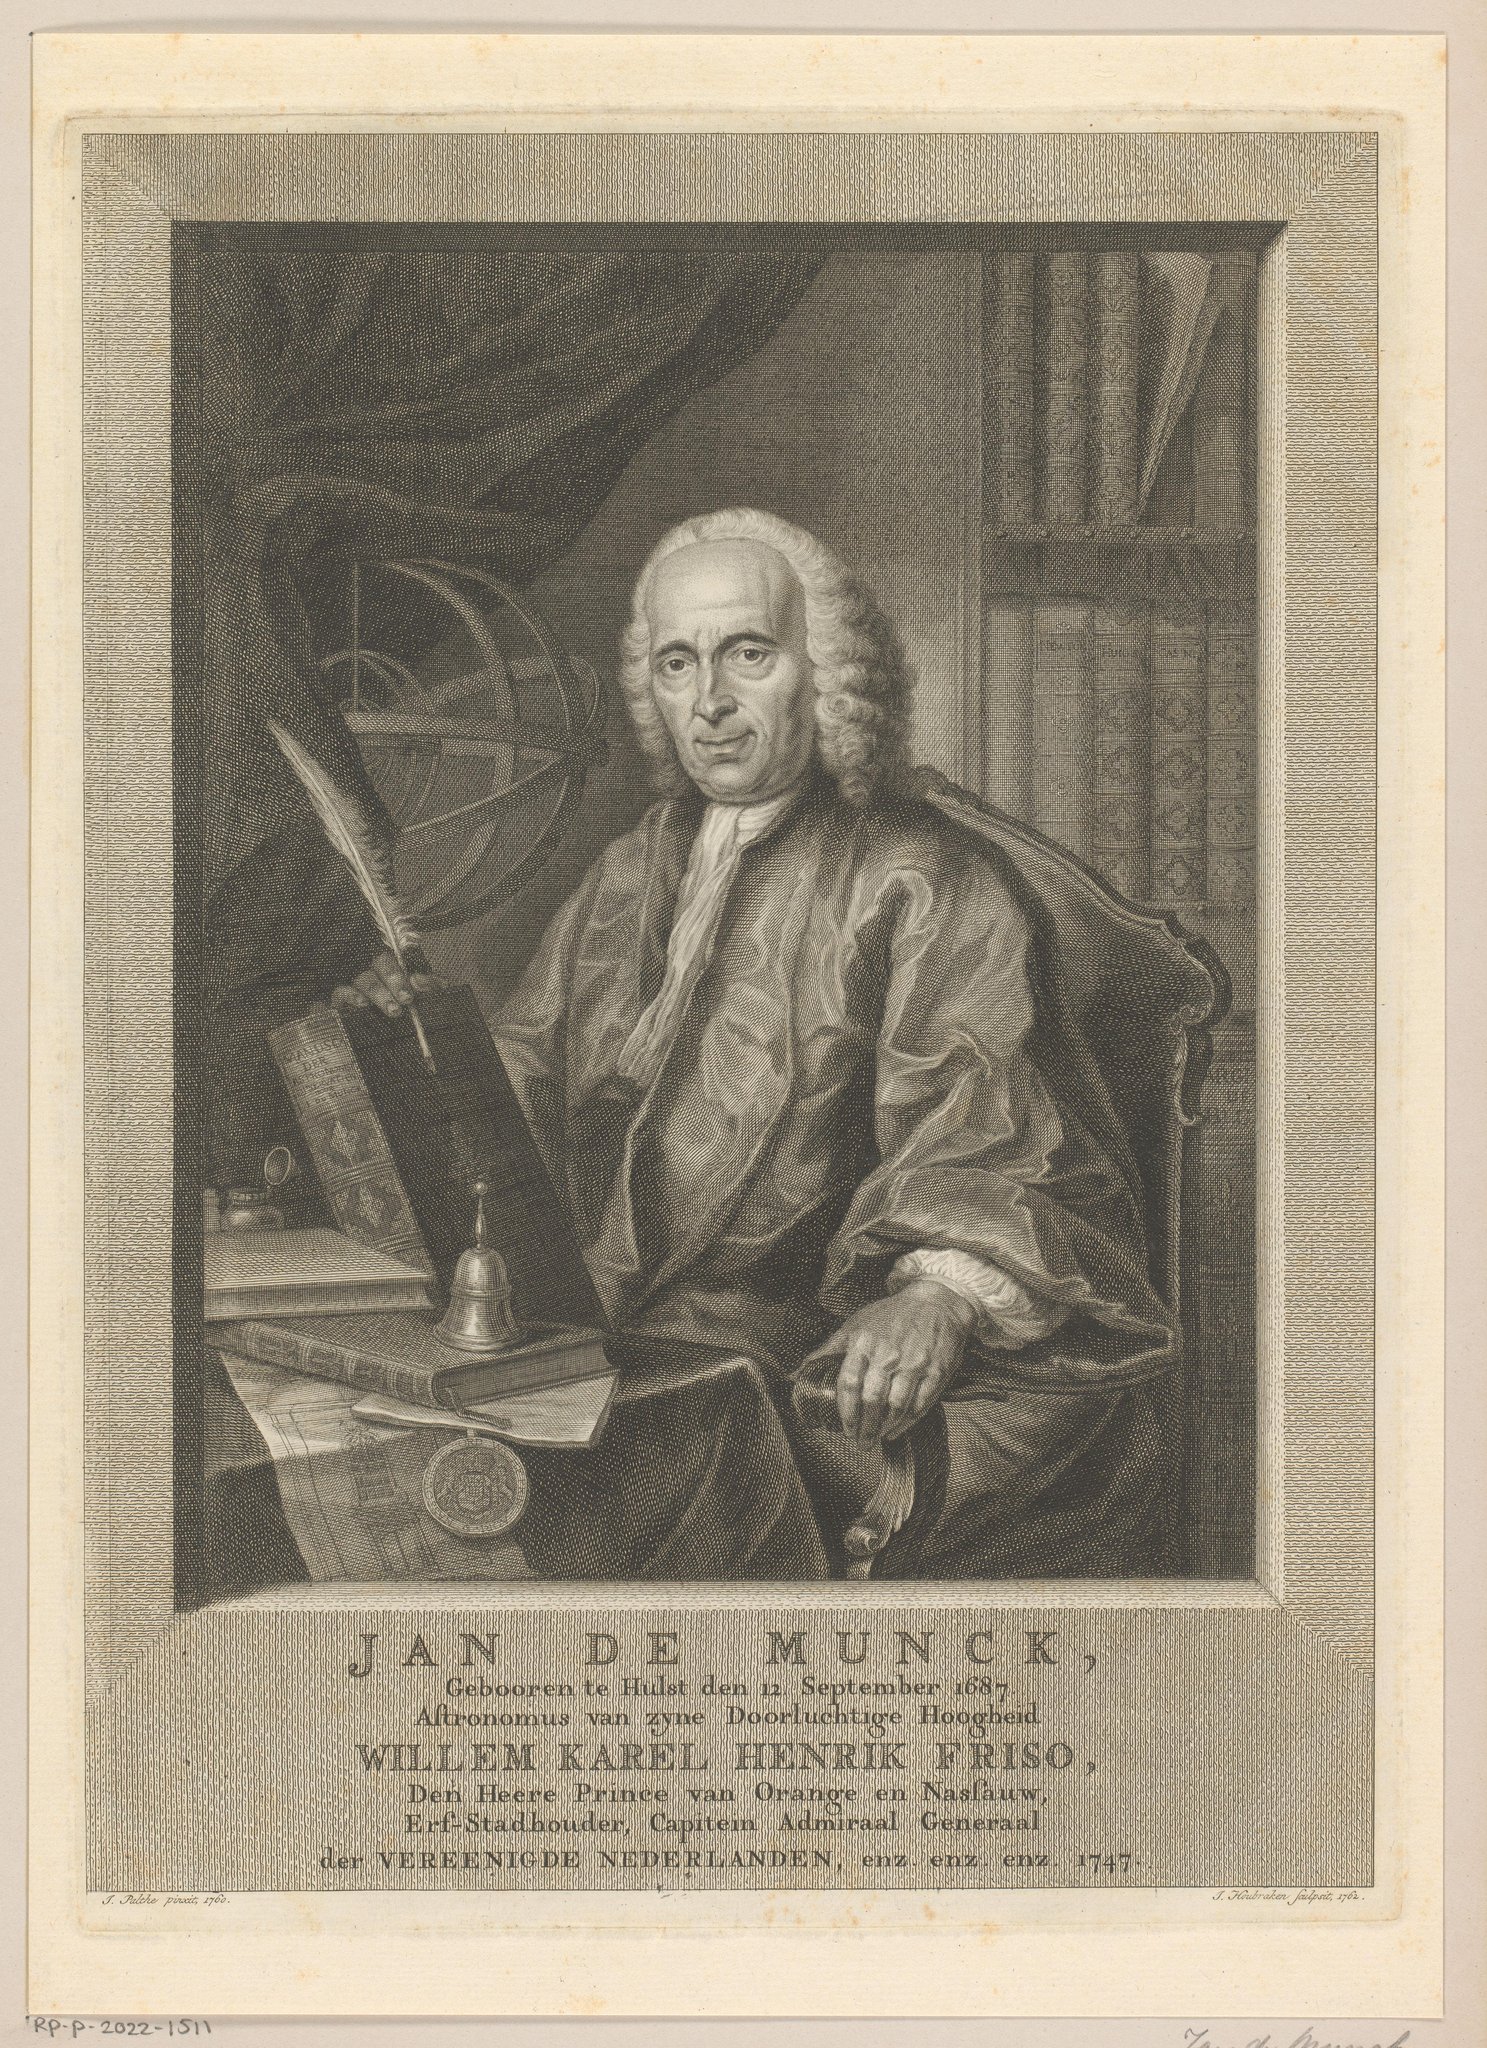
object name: print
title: Portret van Jan de Munck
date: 1762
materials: paper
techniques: engraving, etching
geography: leiden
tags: historical persons, study; 'studiolo'; library